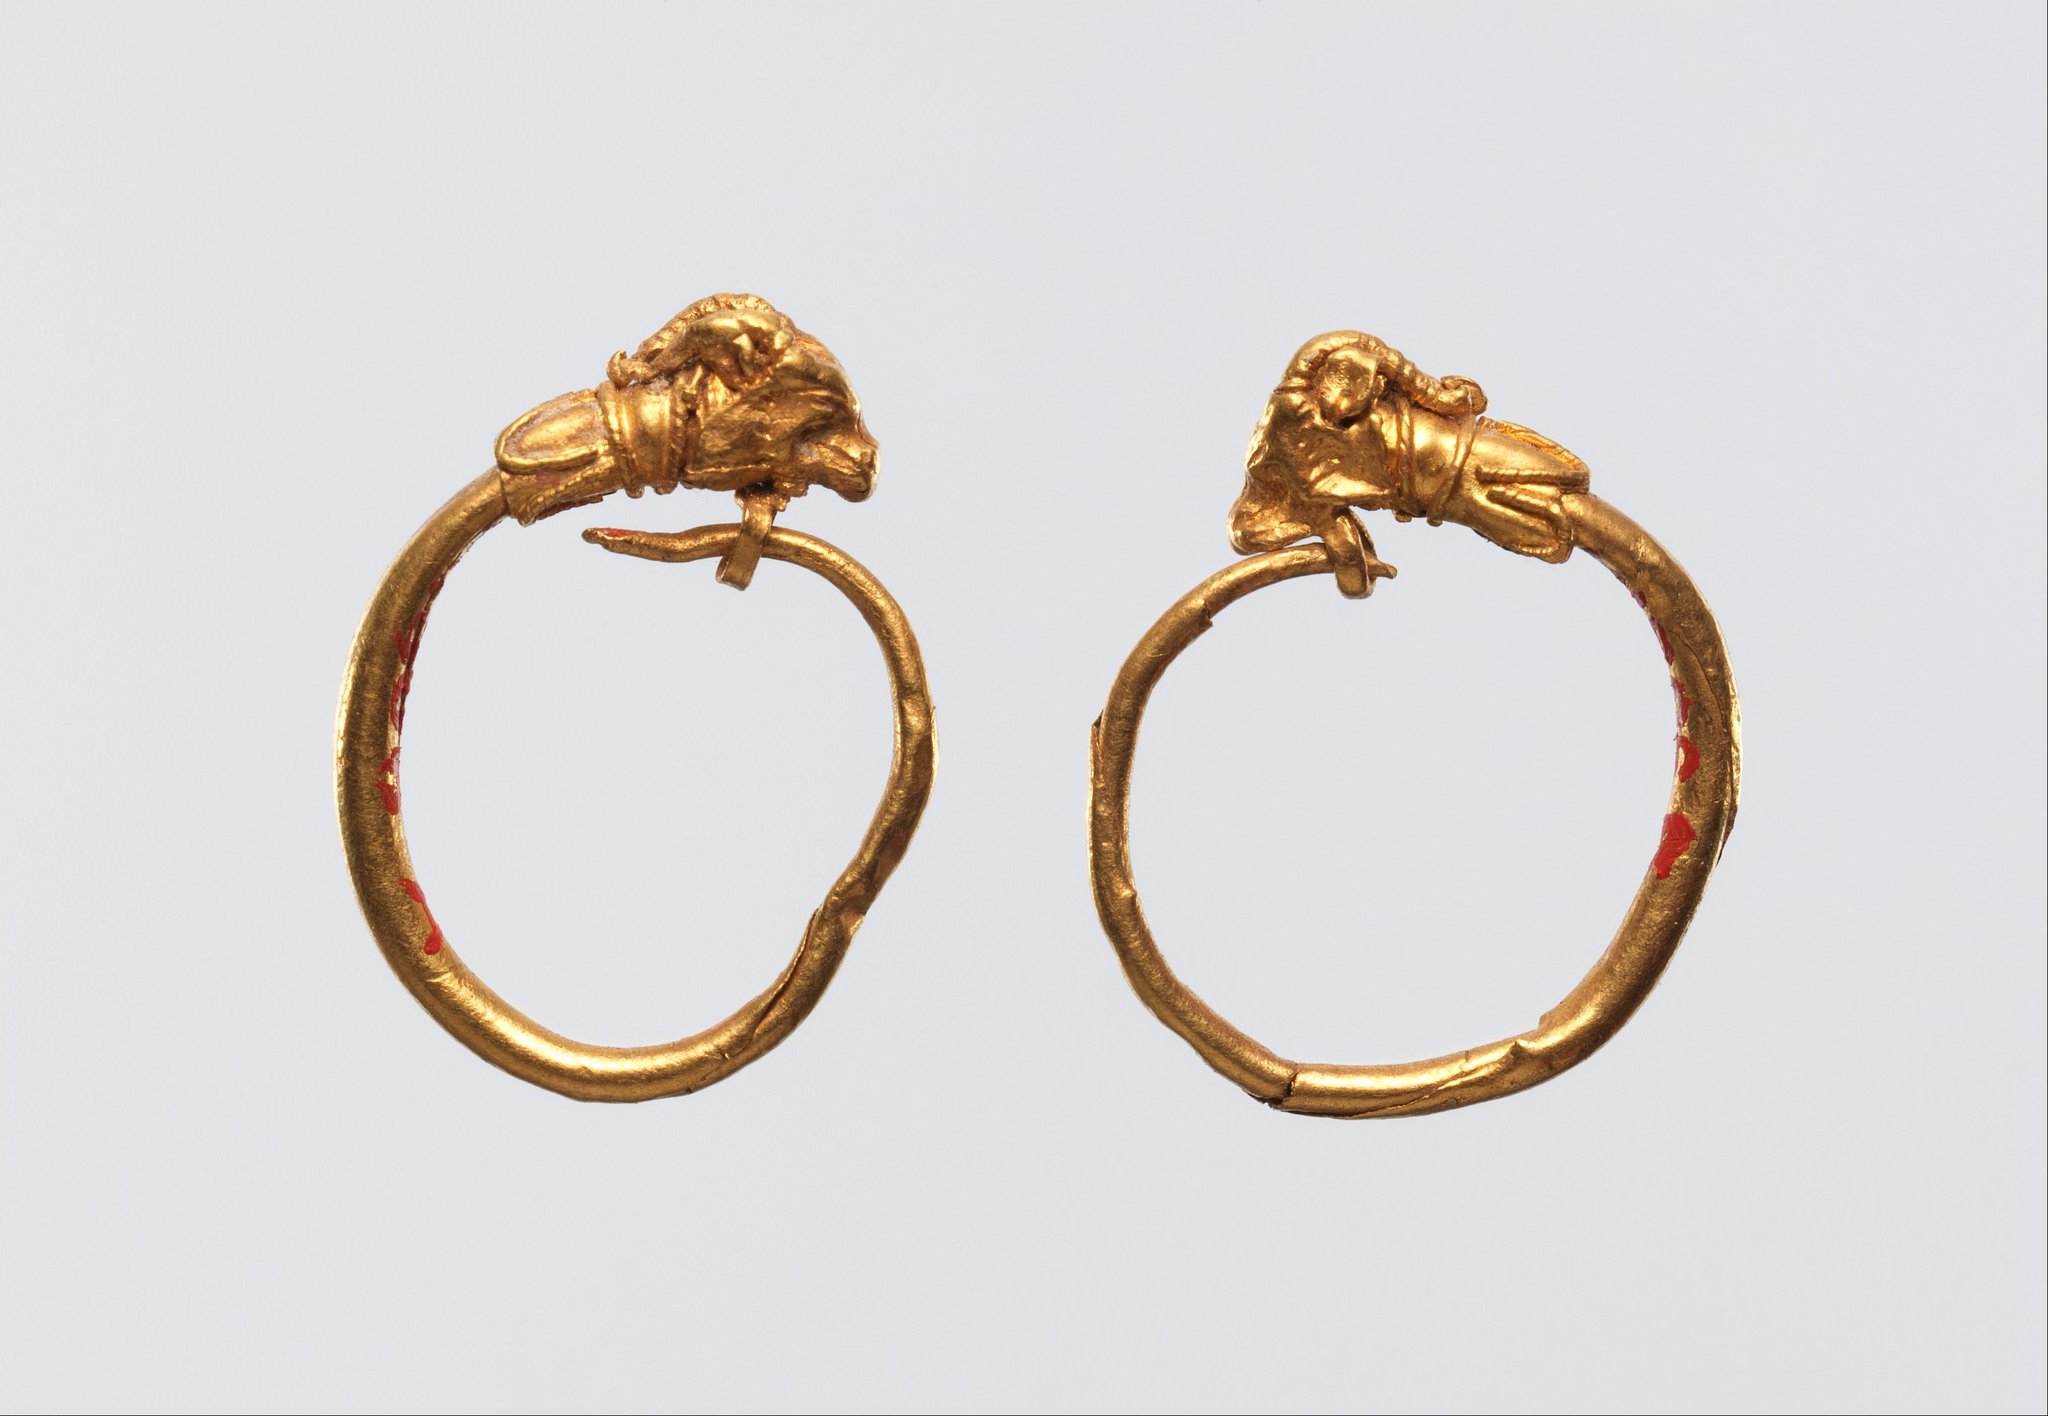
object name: earring, ibex head terminal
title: Earrings with ibex head terminal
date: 101-200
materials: gold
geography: egypt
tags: ibex